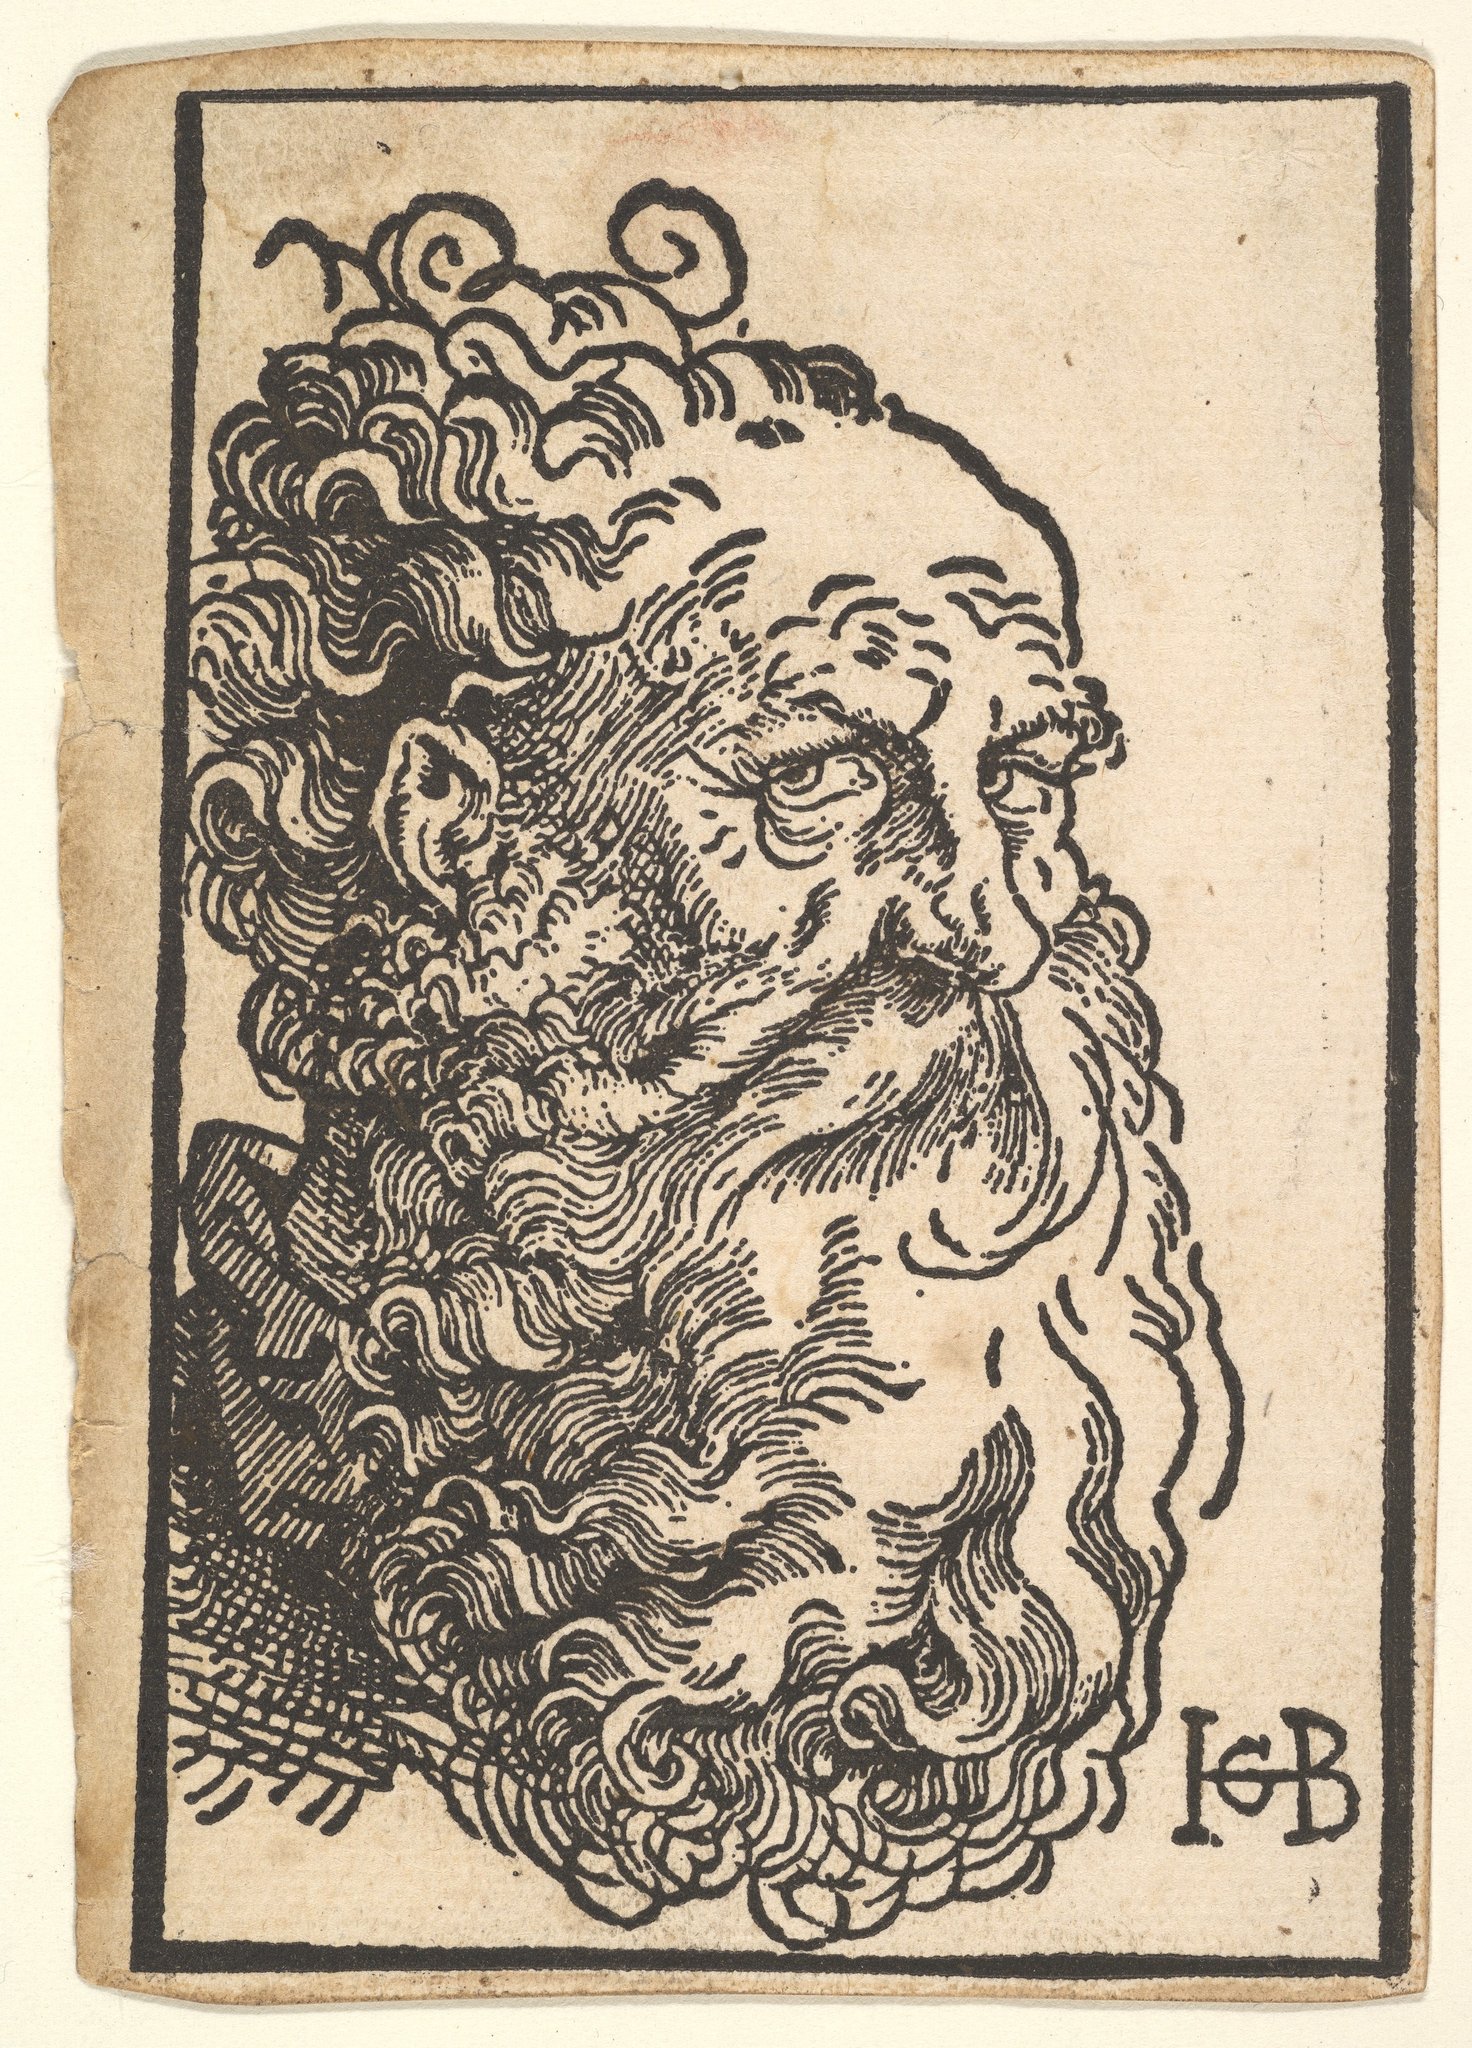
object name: print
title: Head of a Bearded Man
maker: hans baldung (called hans baldung grien)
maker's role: artist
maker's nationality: german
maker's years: 1484-1545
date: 1518-1519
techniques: woodcut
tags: heads,men